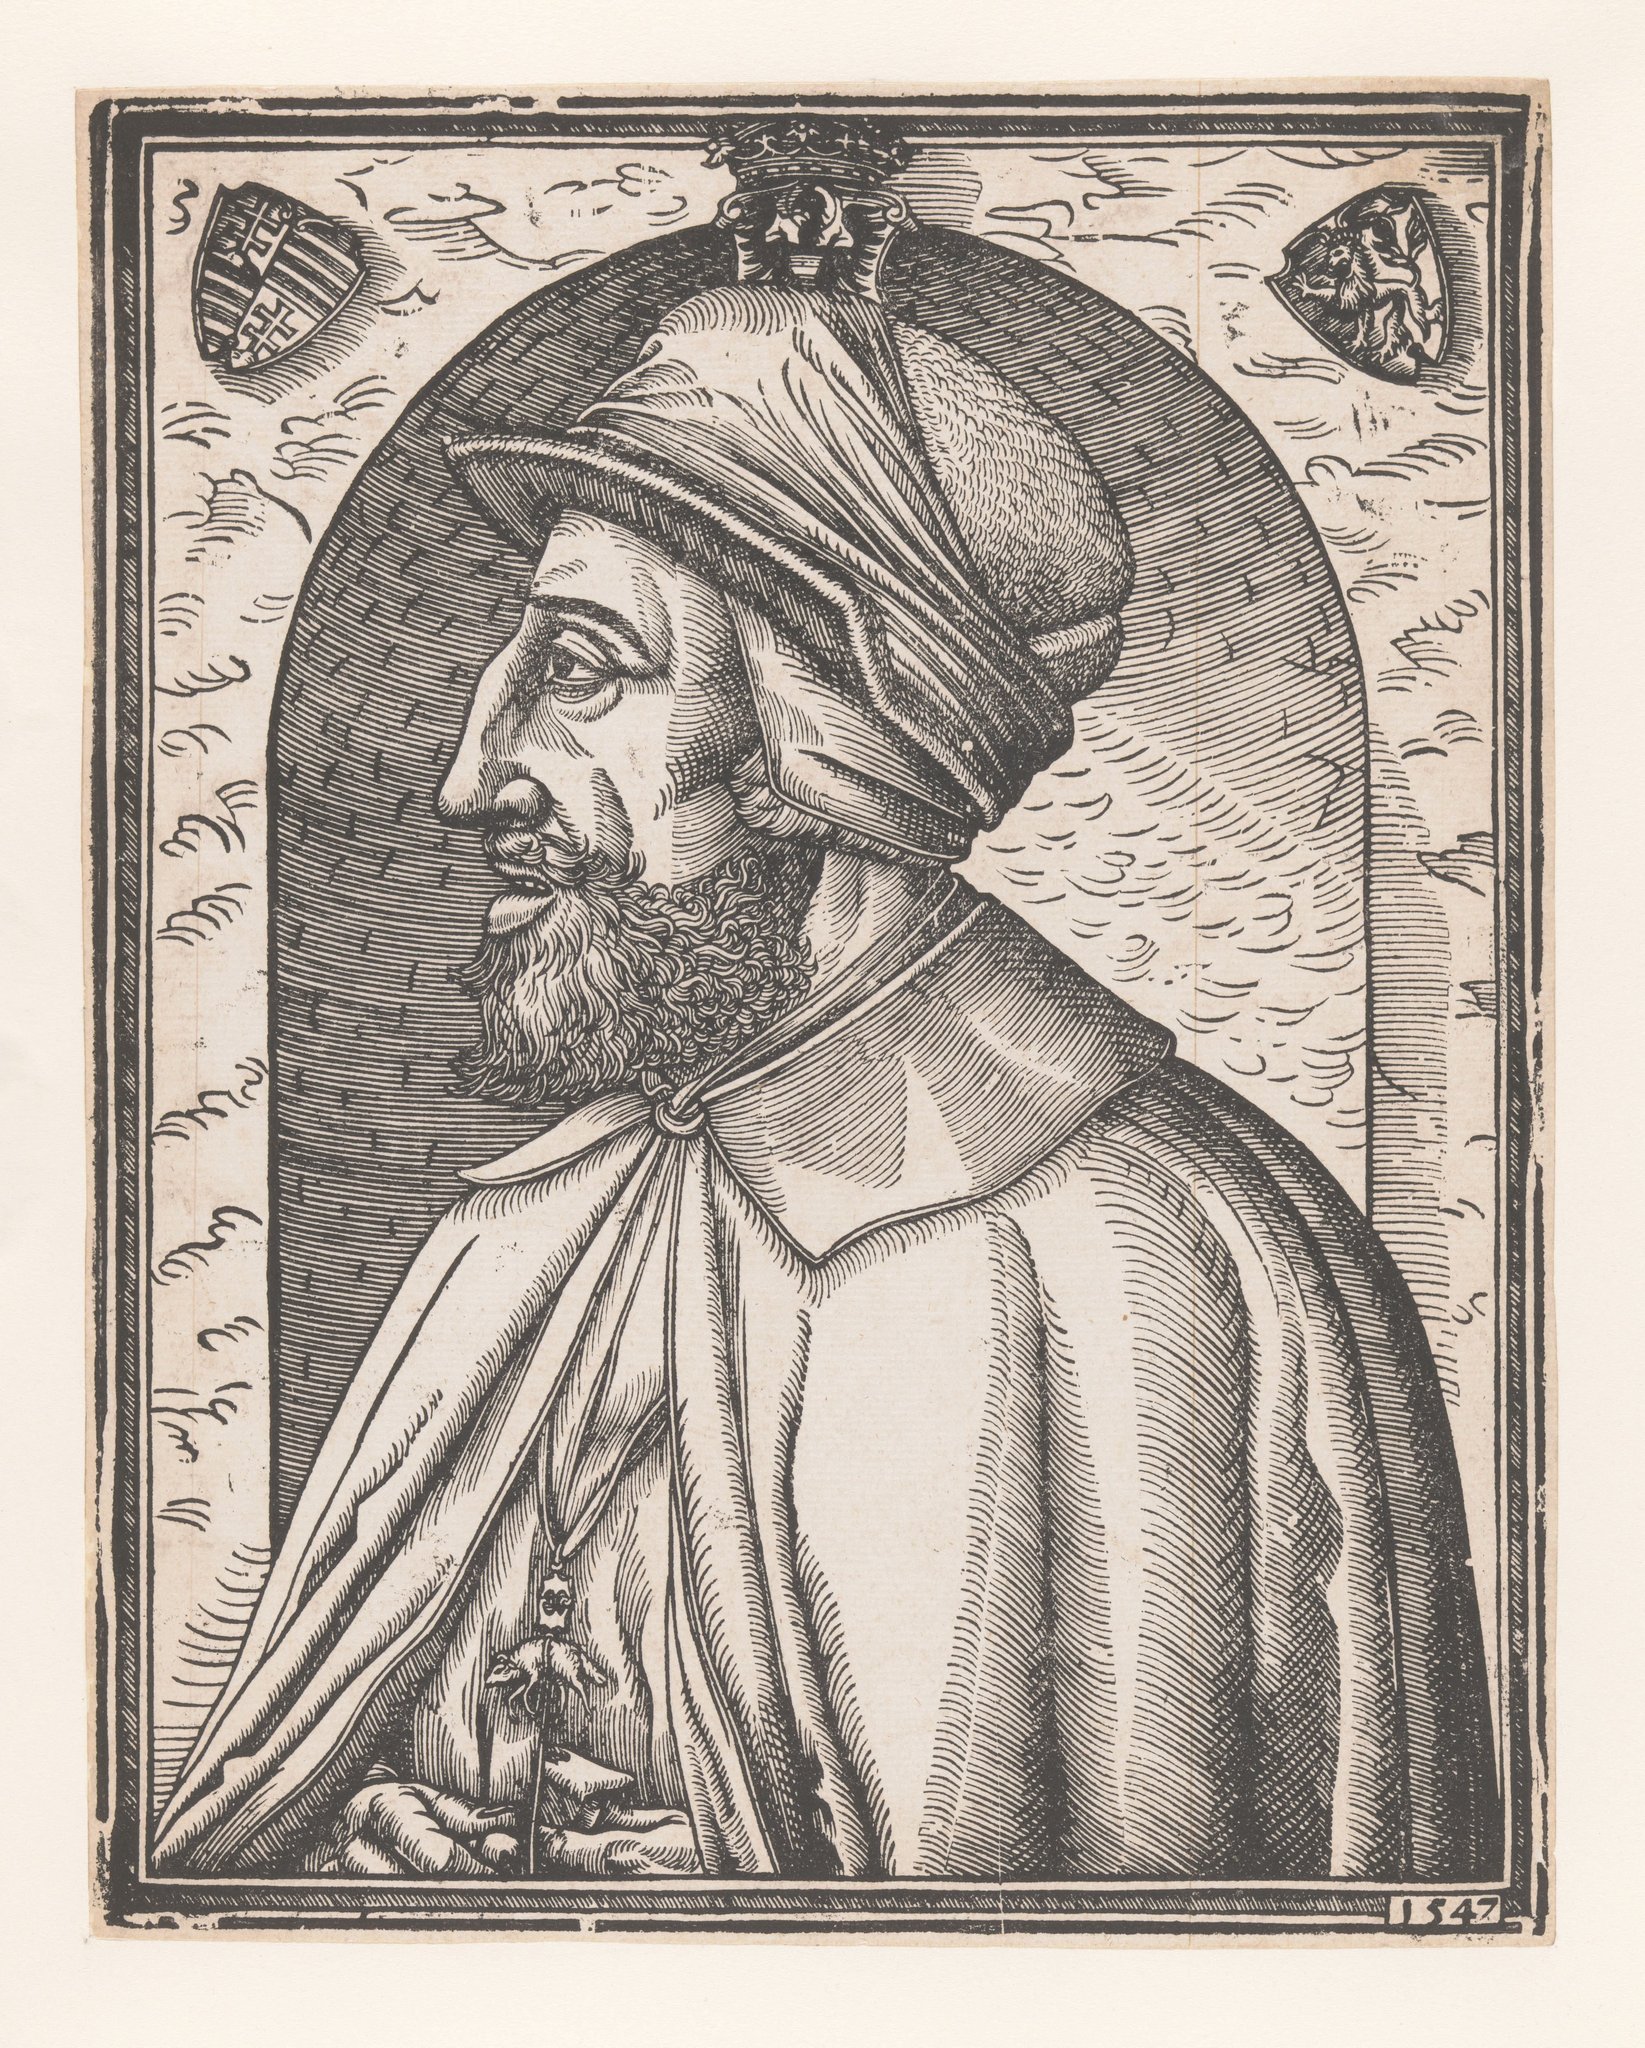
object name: print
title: Portret van keizer Ferdinand I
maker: monogrammist mr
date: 1547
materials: paper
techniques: woodcut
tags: vienna, ferdinand i van habsburg (duits keizer), historical persons, knighthood order of the golden fleece - insignia of a knighthood order, e.g.: badge, chain (with name of order)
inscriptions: collector's mark: Lugt 2228